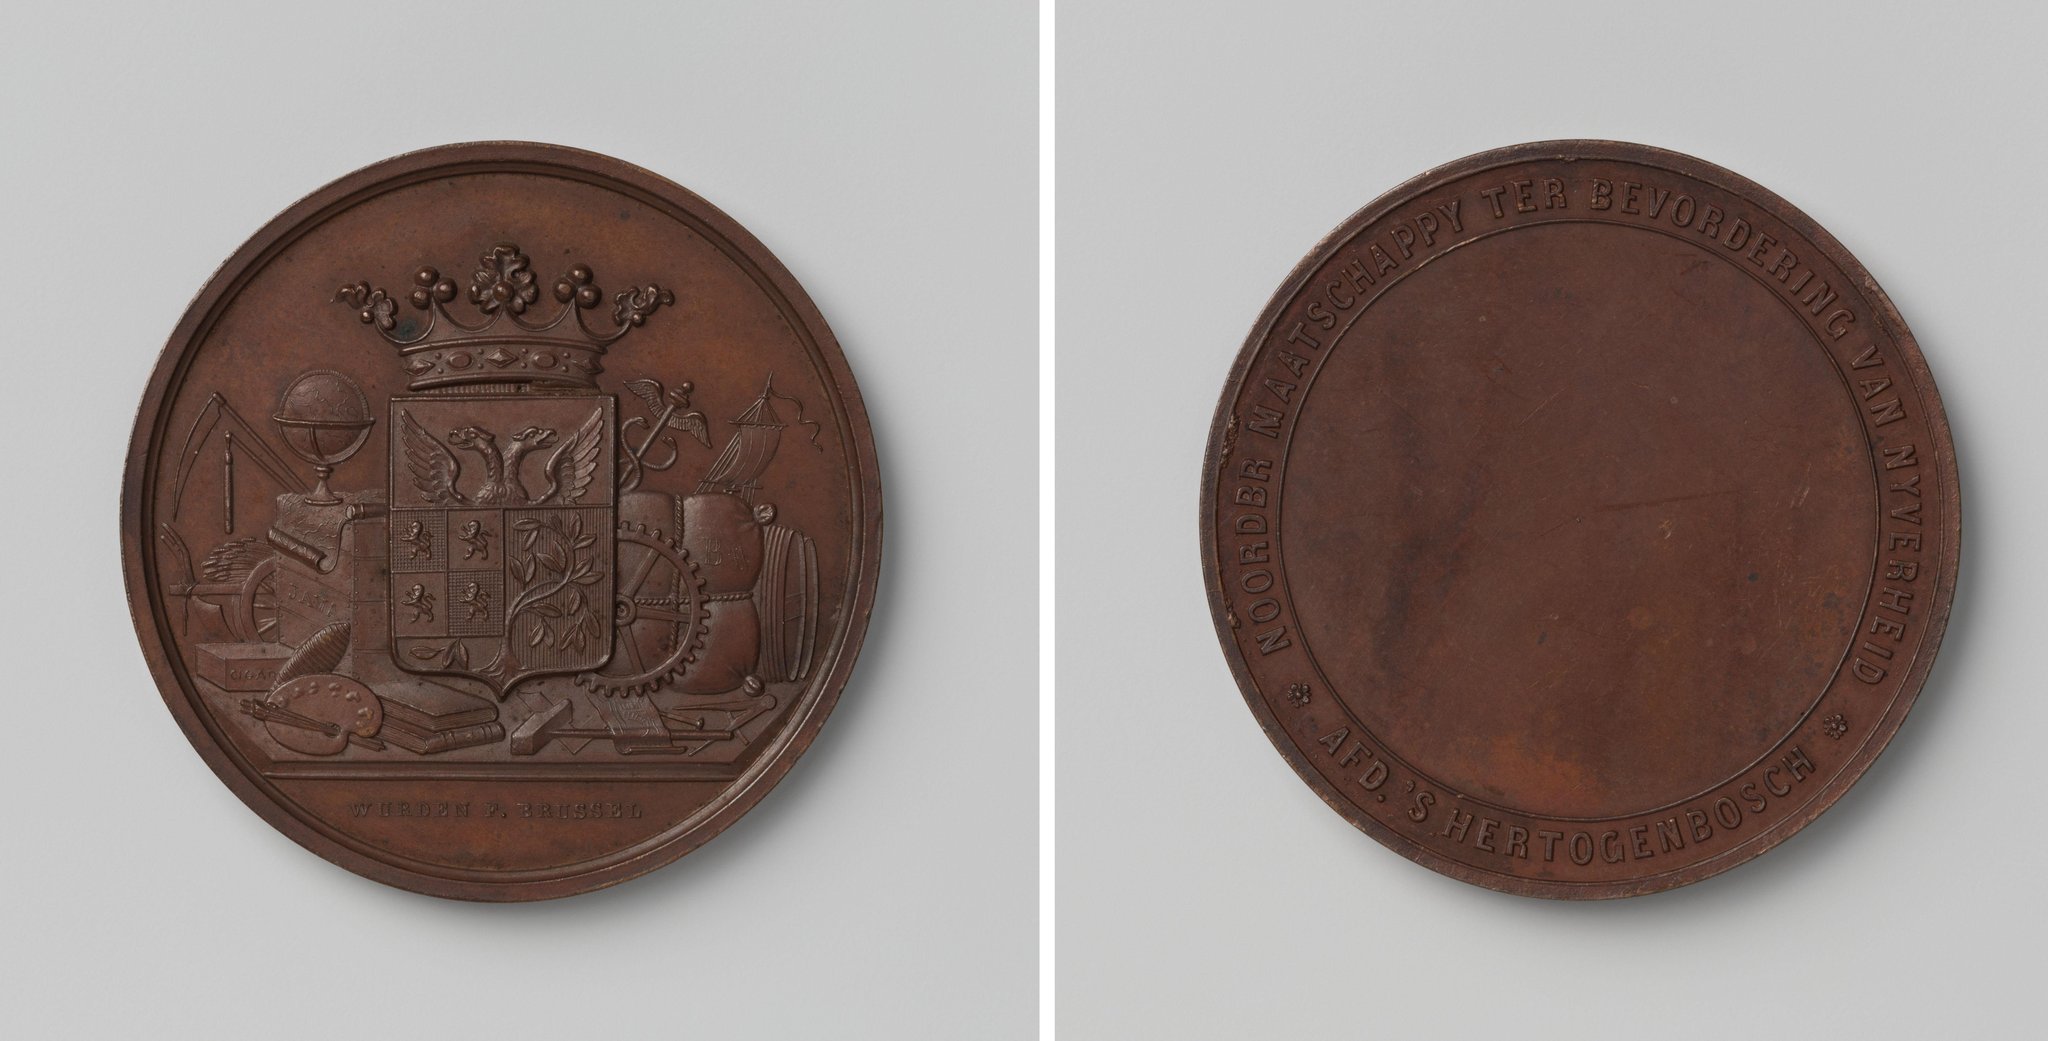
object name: medal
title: Noordbrabantse Maatschappij ter Bevordering van Nyverheid, Afdeling 's-Hertogenbosch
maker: jean wurden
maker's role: medailleur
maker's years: 1807-1874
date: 1855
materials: bronze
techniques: striking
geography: brussels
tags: den bosch